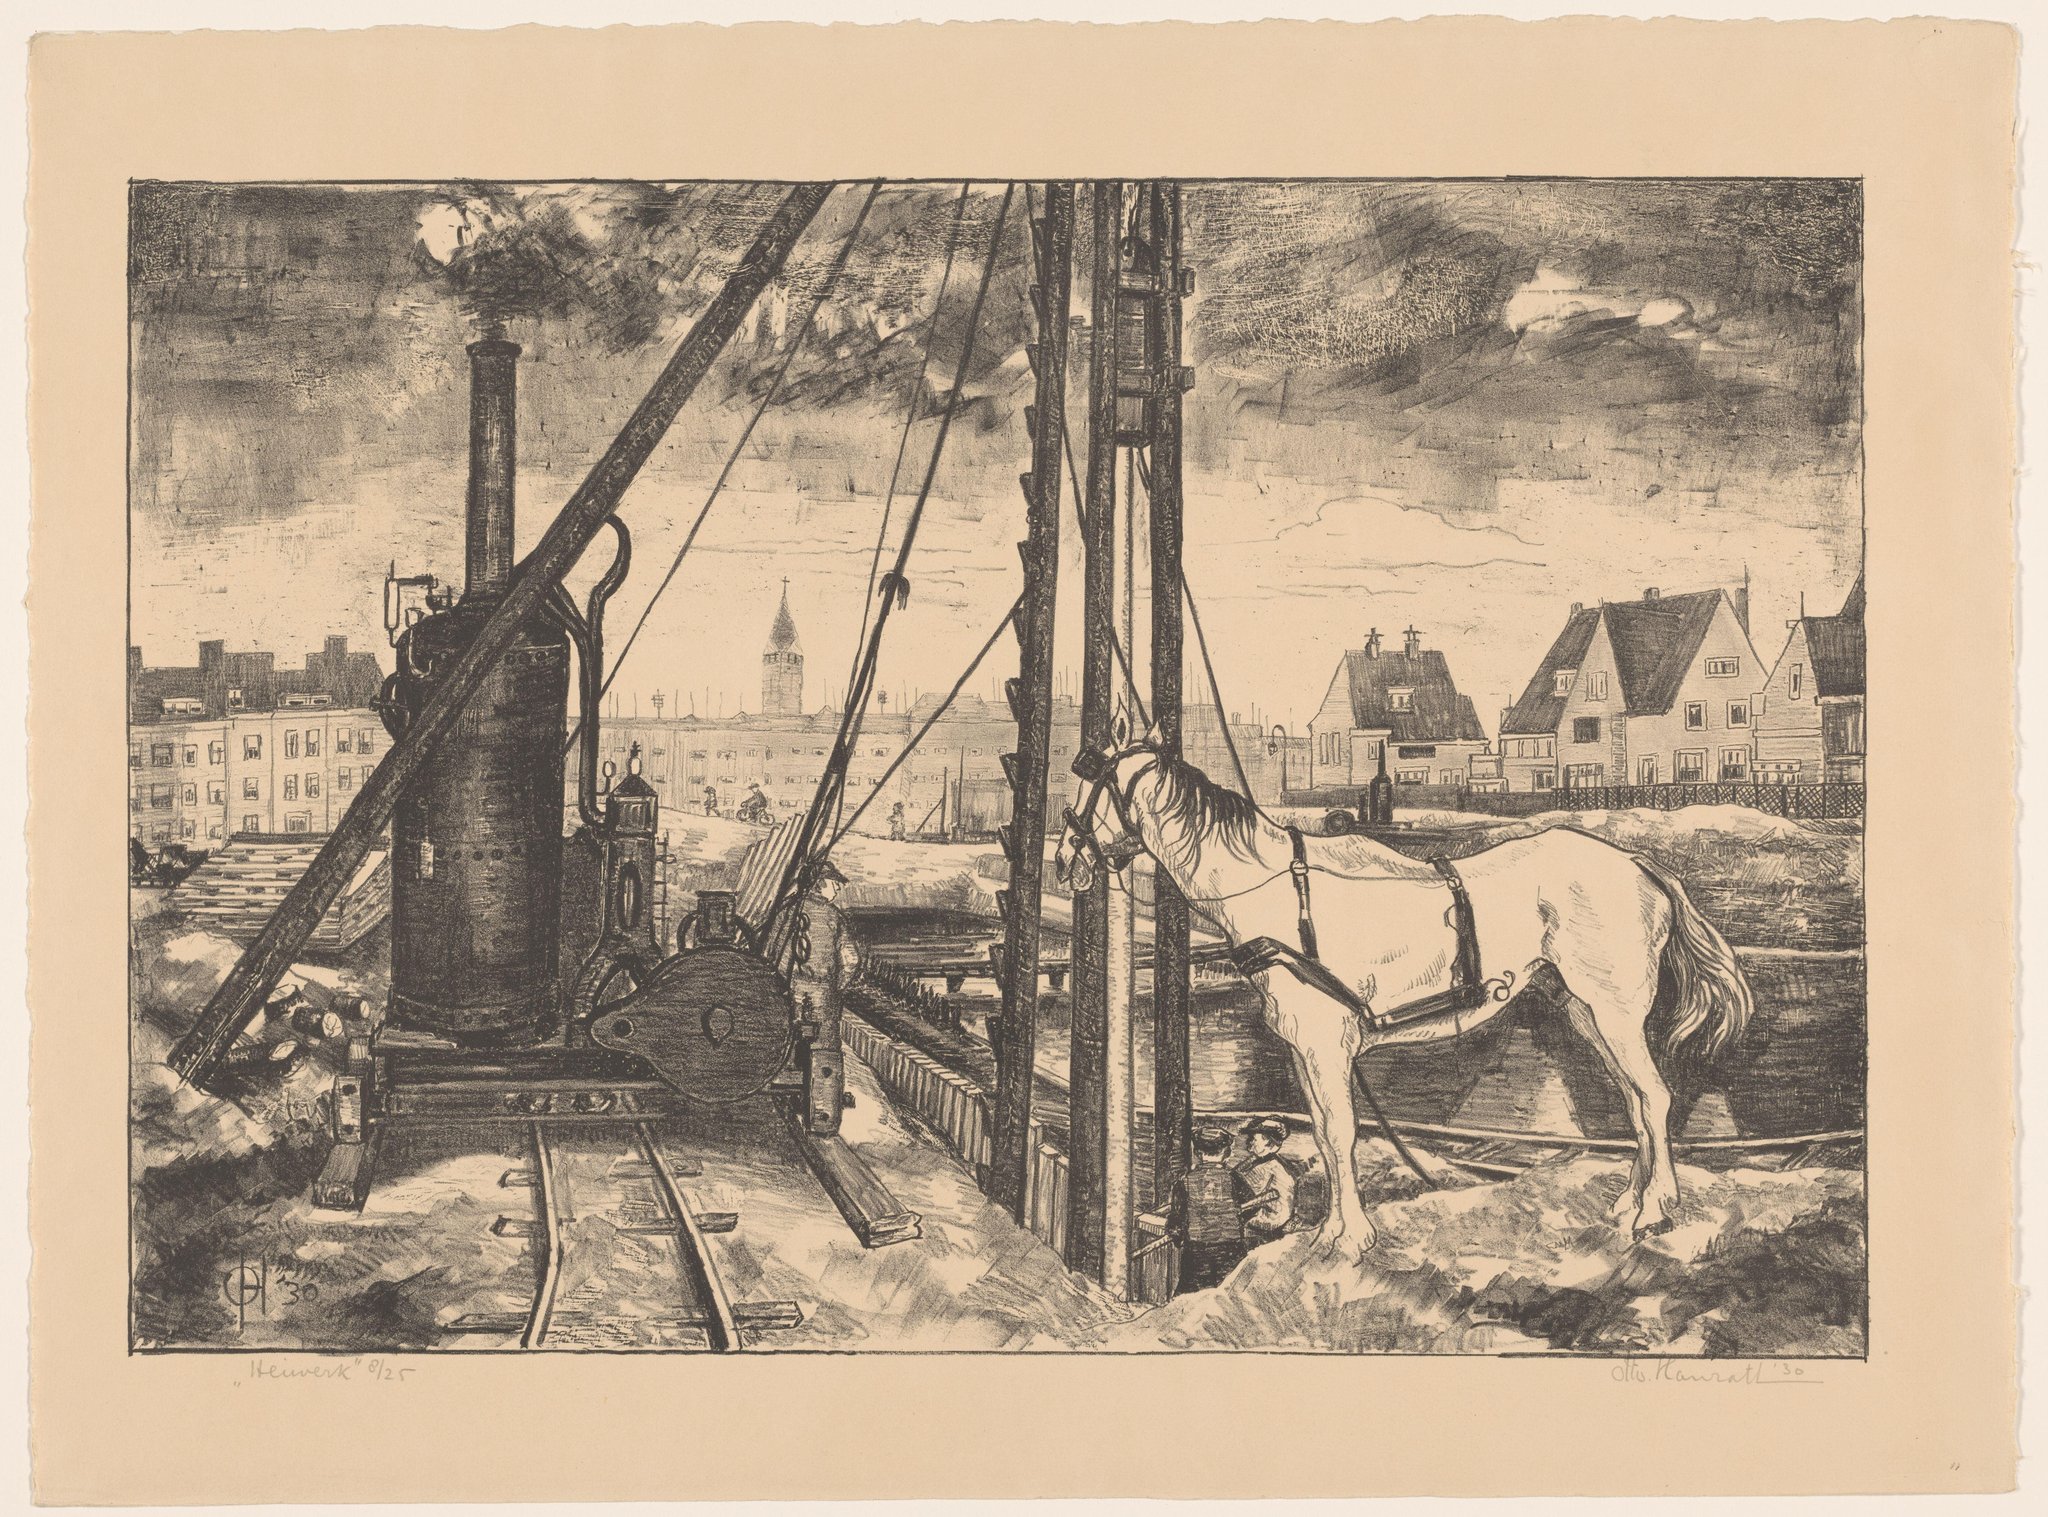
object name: print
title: Heiwerk voor de aanleg van het Vossius Gymnasium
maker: otto hanrath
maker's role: print maker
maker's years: 1882-1944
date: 1930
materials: paper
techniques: lithograph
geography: amsterdam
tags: ramming, driving piles (~ building activities), city-view, and landscape with man-made constructions, horse-sleigh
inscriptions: collector's mark: Lugt 2228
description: Een werkpaard bij een stoomheimachine. Op de achtergrond de kerktoren van de Vredeskerk aan de Pijnackerstraat.